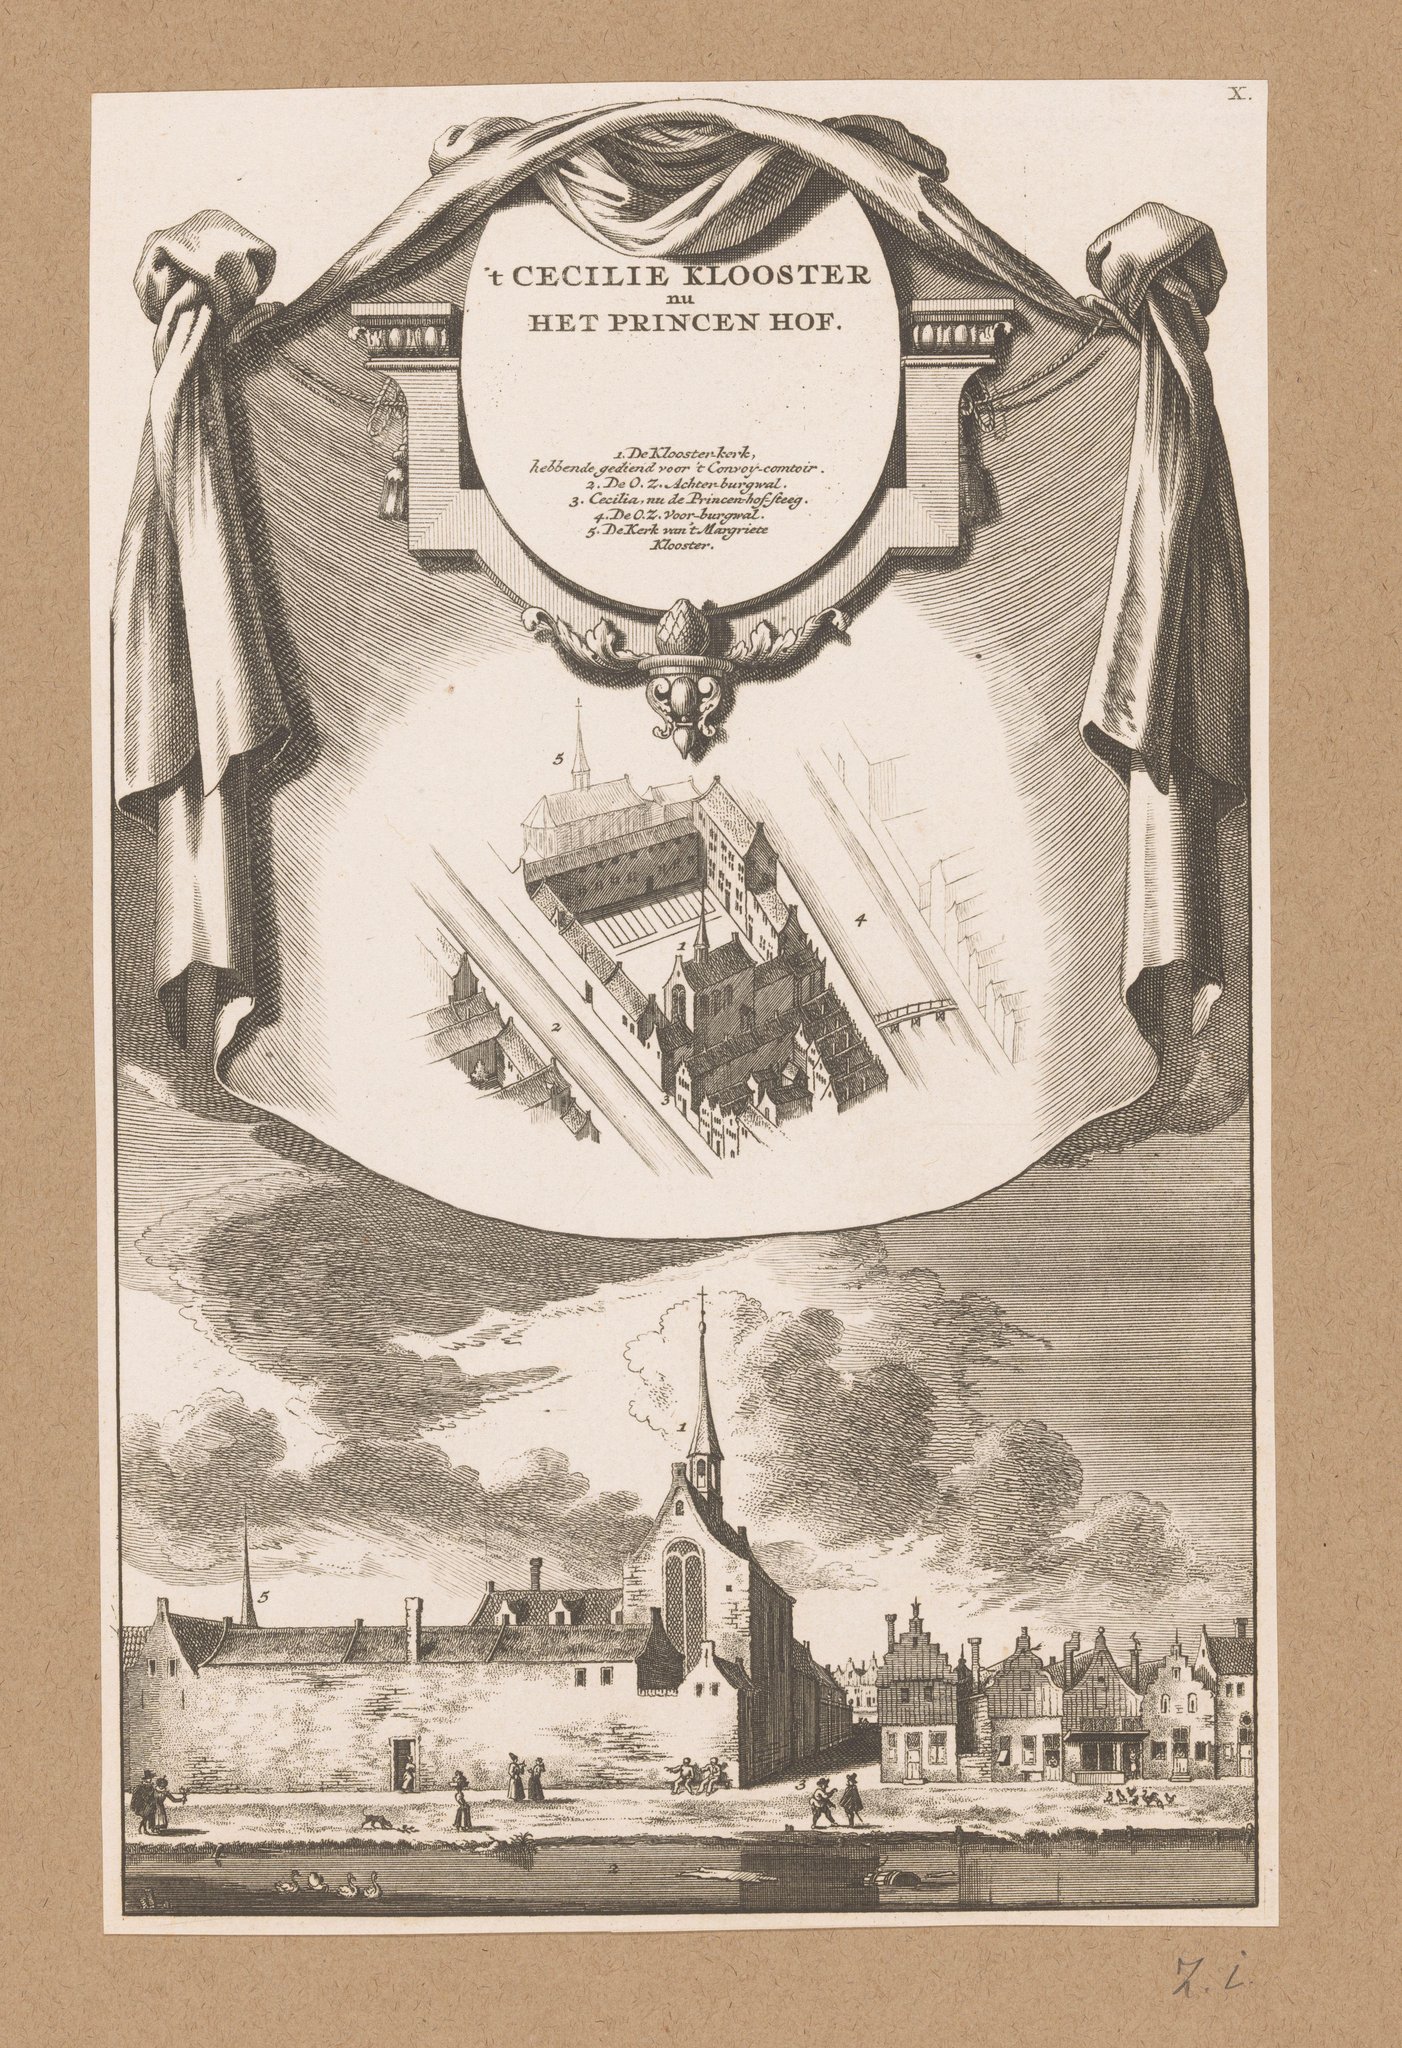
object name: print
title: 't Cecilie Klooster nu het Princen Hof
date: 1760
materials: paper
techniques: engraving, etching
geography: amsterdam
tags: abbey, monastery, convent ~ roman catholic church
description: Prent ook gebruikt in: Wagenaar, Jan. Amsterdam, in zyne opkomst, aanwas, geschiedenissen (…). 3 dln. [folio-uitgave]. Amsterdam: Isaak Tirion en Yntema & Tieboel, 1760-1767, dl. 1 (Isaac Tirion, 1760). Zie RP-P-AO-24X-20 voor proefdruk. Dat de prent de situatie rond 1544 weergeeft gaat terug op het feit dat voor het maken van deze en andere prenten van kloosters en kerken van voor de Alteratie (1578) is uitgegaan van de plattegrond van Cornelis Anthonisz. uit 1544 (zie RP-P-OB-70.399 en RP-P-AO-20-15).